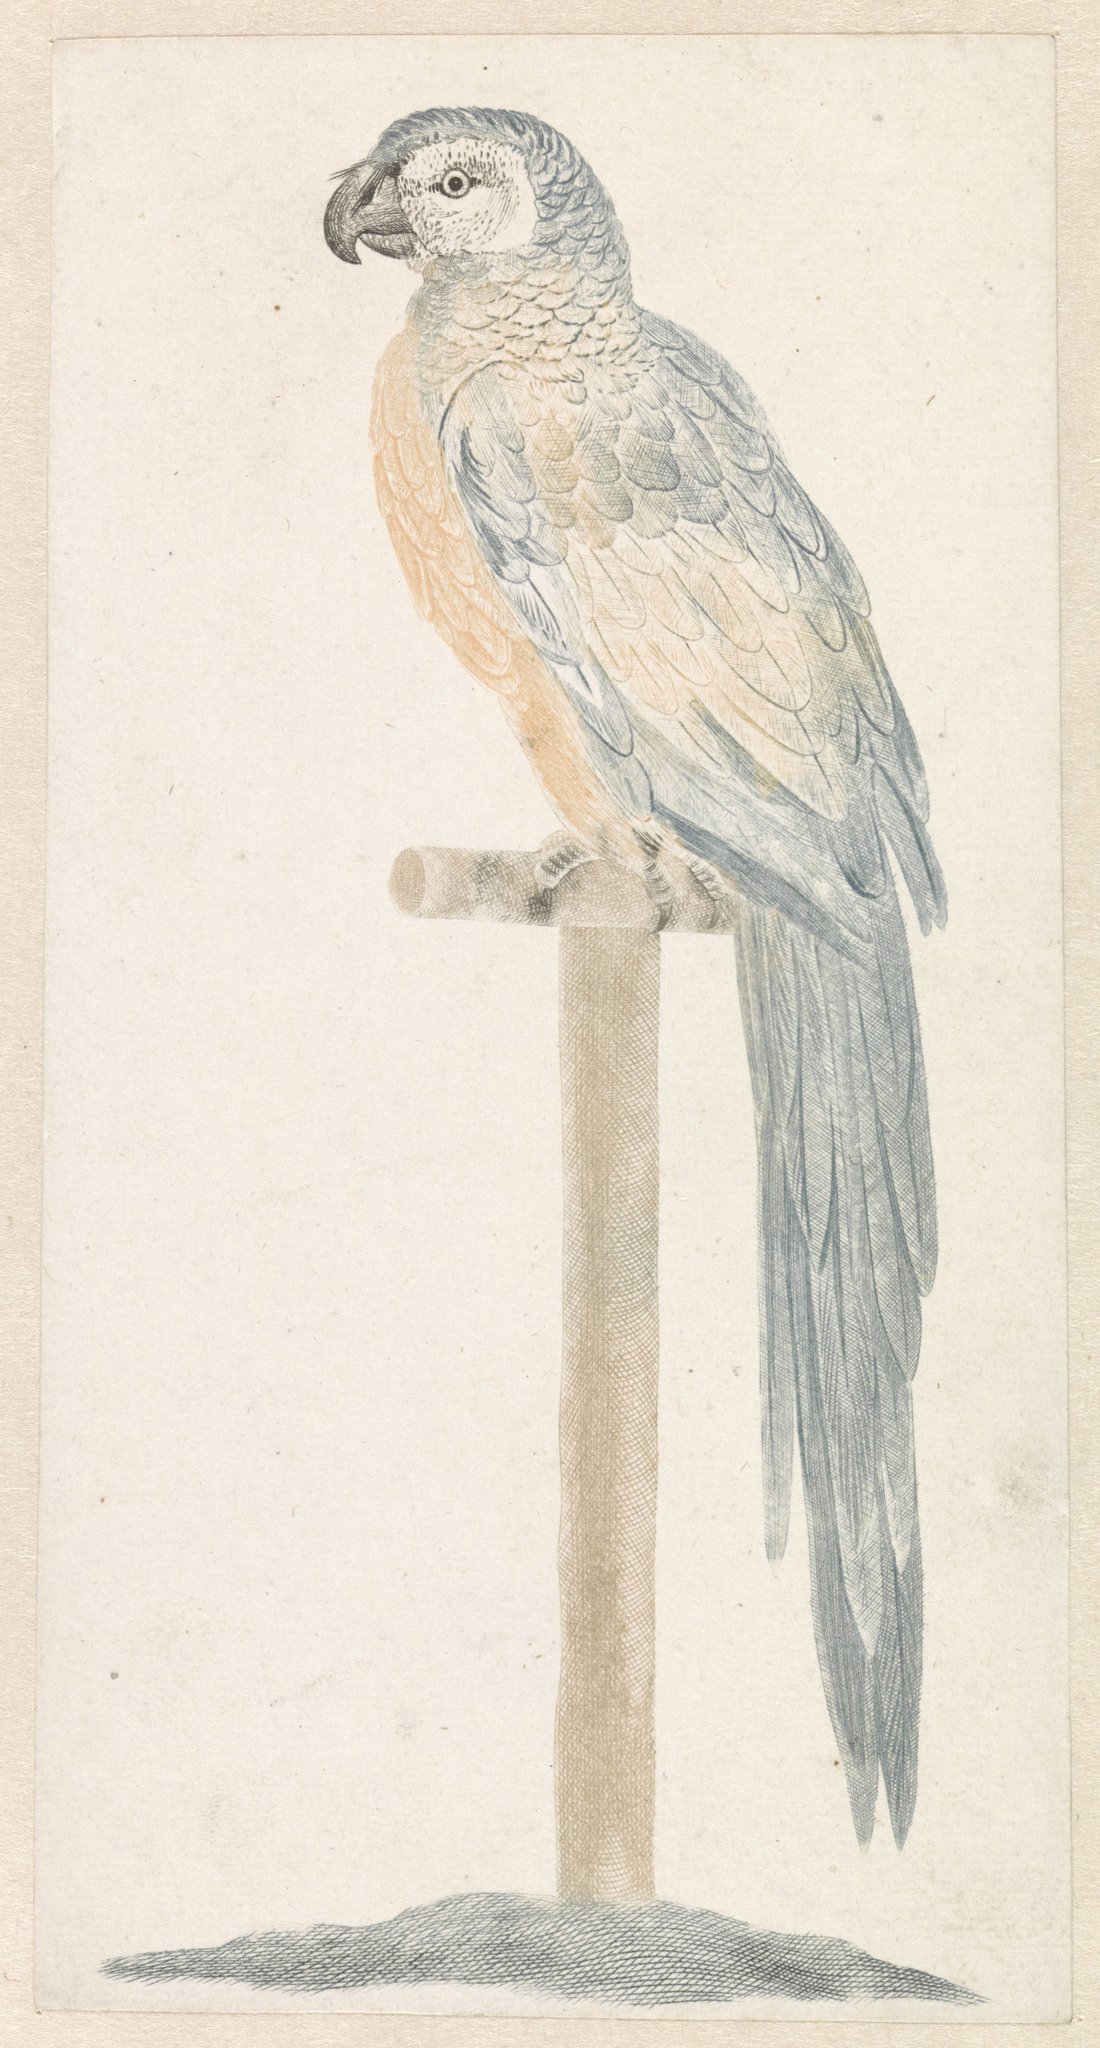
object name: print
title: Papegaai op stok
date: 1688-1698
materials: paper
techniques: printing, engraving, lithography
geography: netherlands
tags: ornamental birds: parrot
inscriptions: collector's mark: Lugt 2228